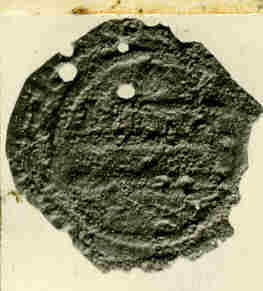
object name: coin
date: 767-775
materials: copper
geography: iran